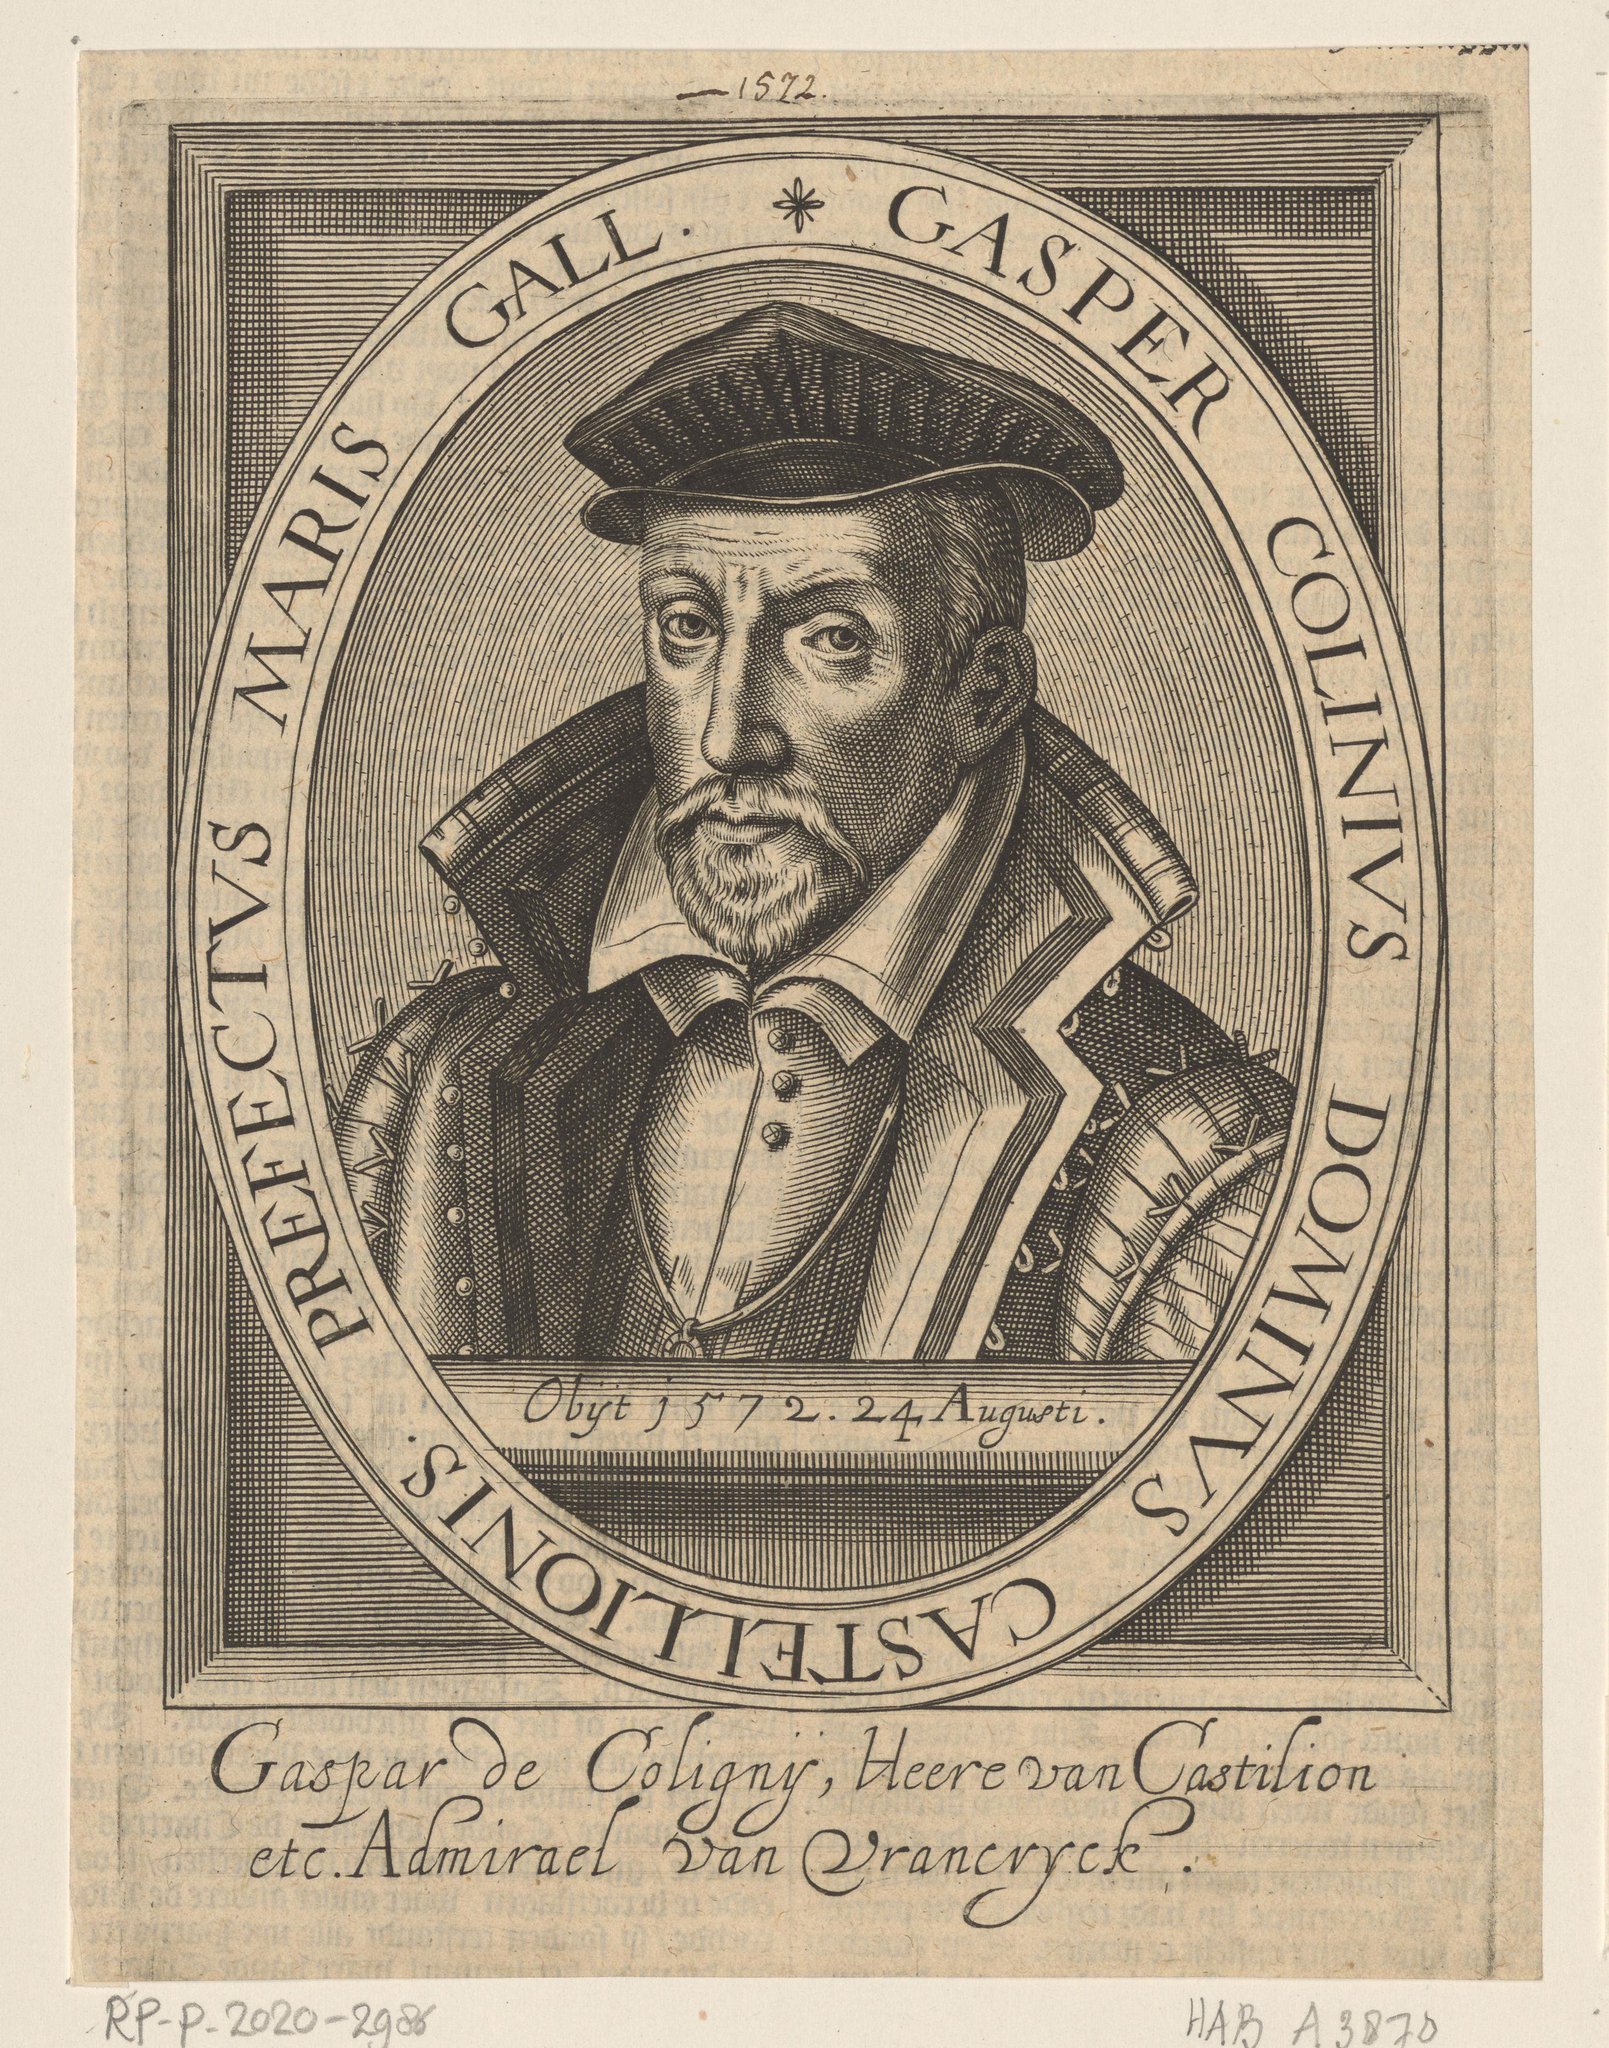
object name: print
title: Portret van Gaspard de Coligny II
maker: Anonymous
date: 1614-1635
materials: paper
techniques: engraving, letterpress printing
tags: paris, politician, gaspard de coligny (ii), historical persons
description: Prent mogelijk uit: Meterens, Emanuel van. Historie van de oorlogen en geschiedenissen der Nederlanderen, en der zelver naburen. Amsterdam: Johannes Janssonius, 1614. Of een latere editie (1623, 1635).